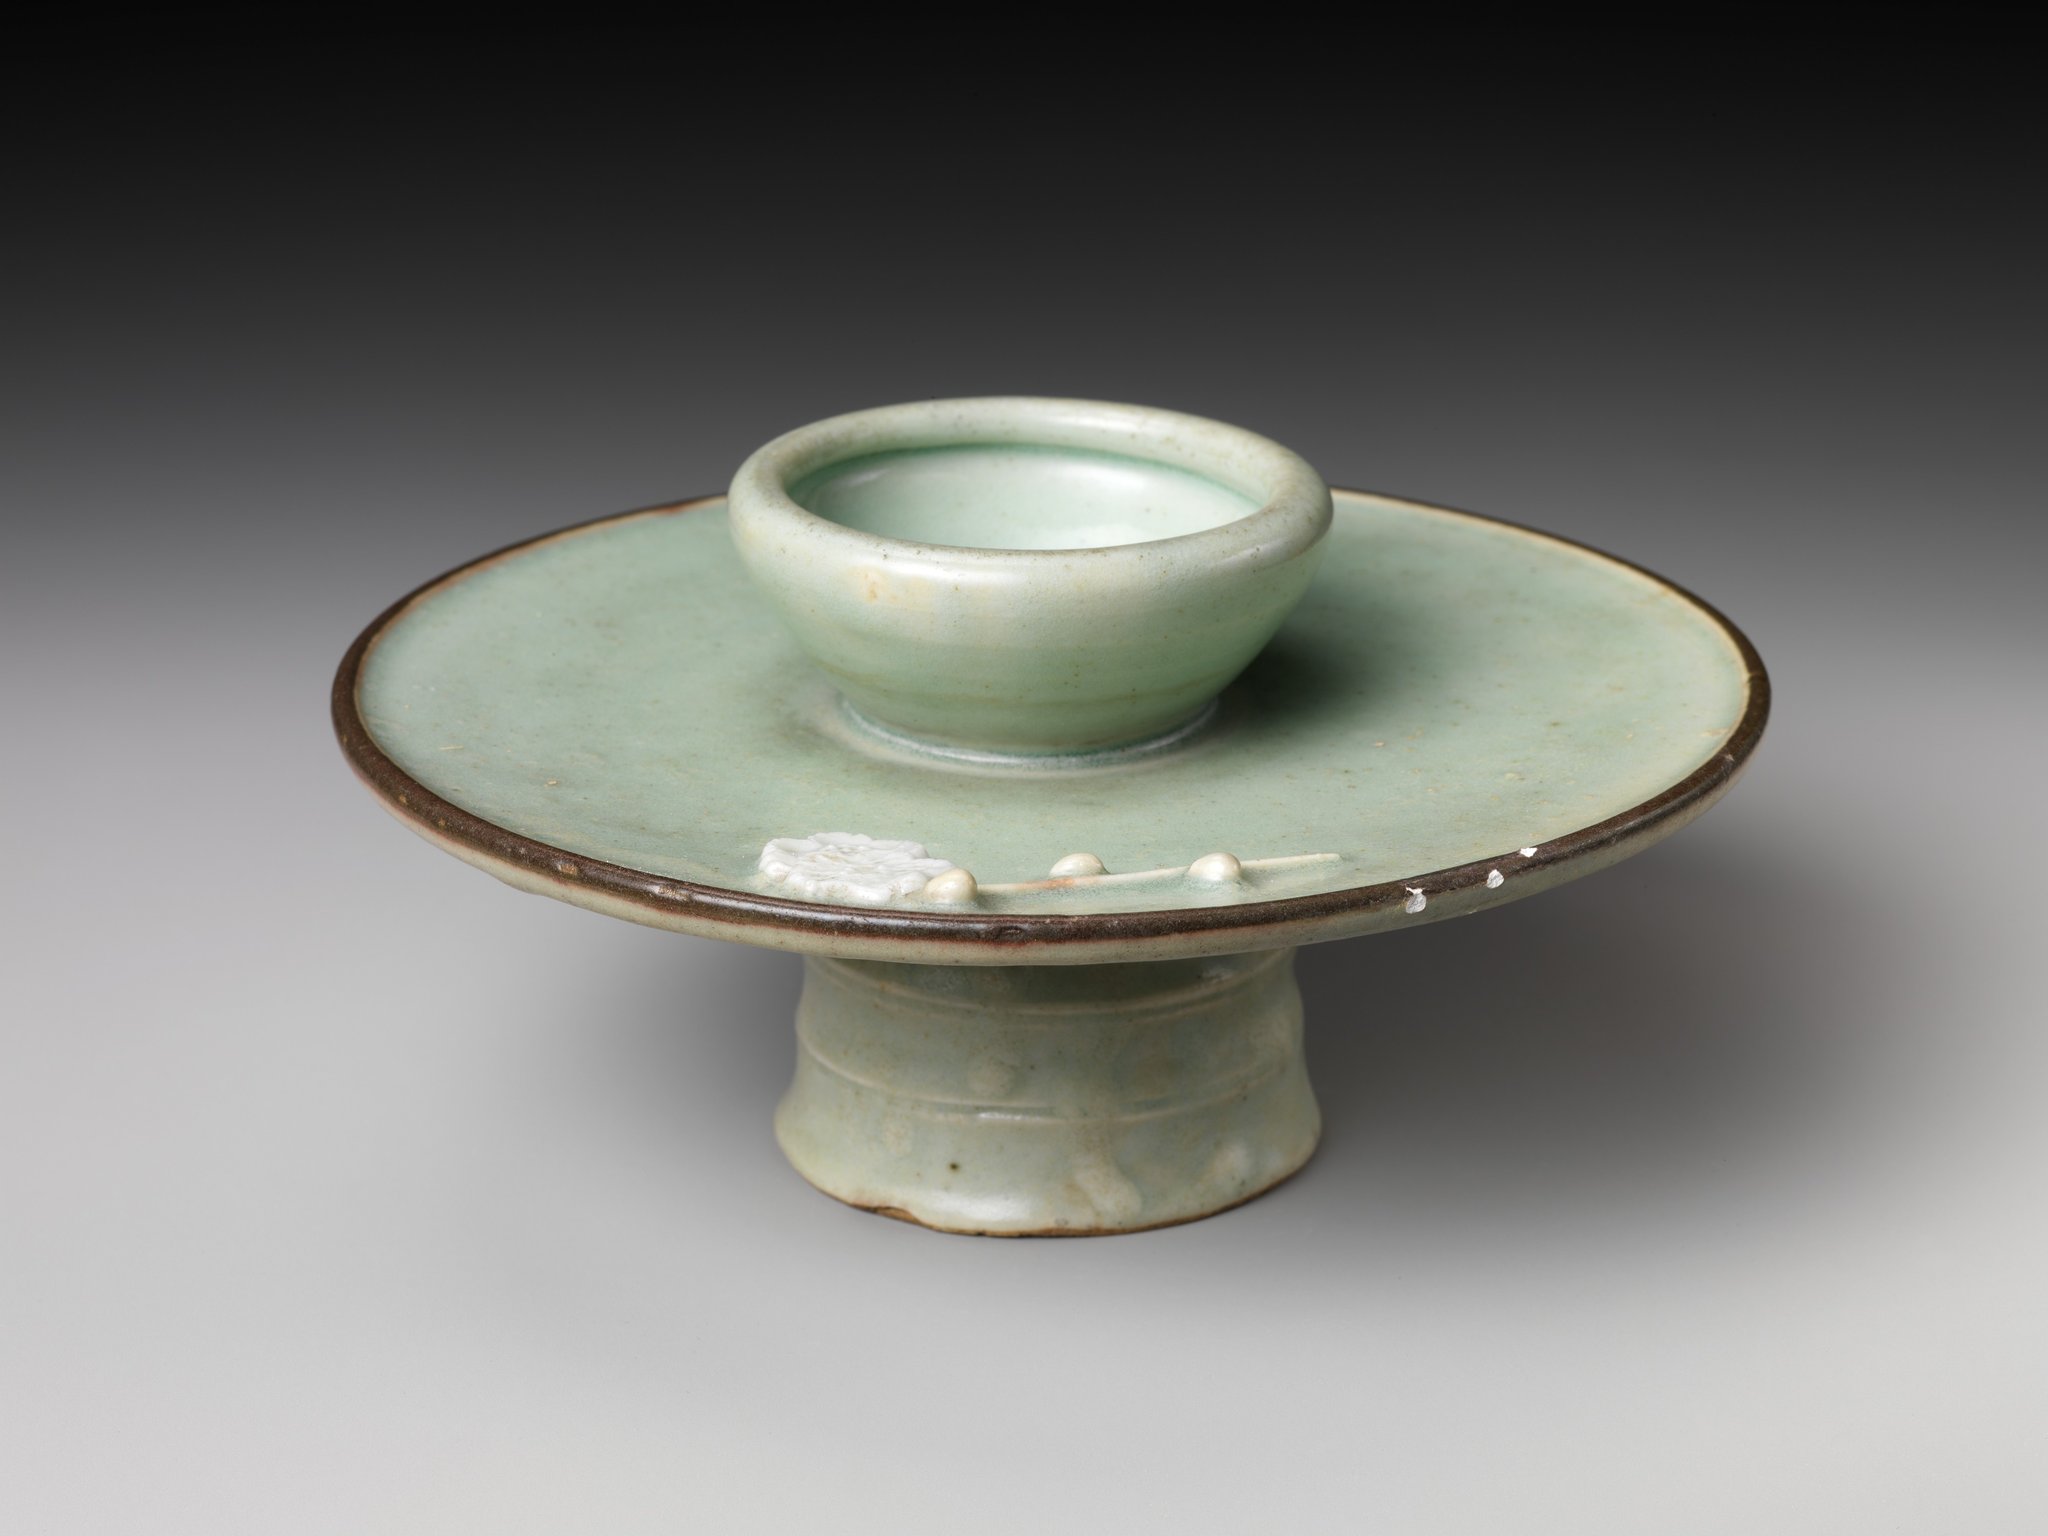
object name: cup stand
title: Cup Stand with Floral Design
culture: japanese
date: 1615-1868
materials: ceramic glaze, glaze, porcelain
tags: flowers